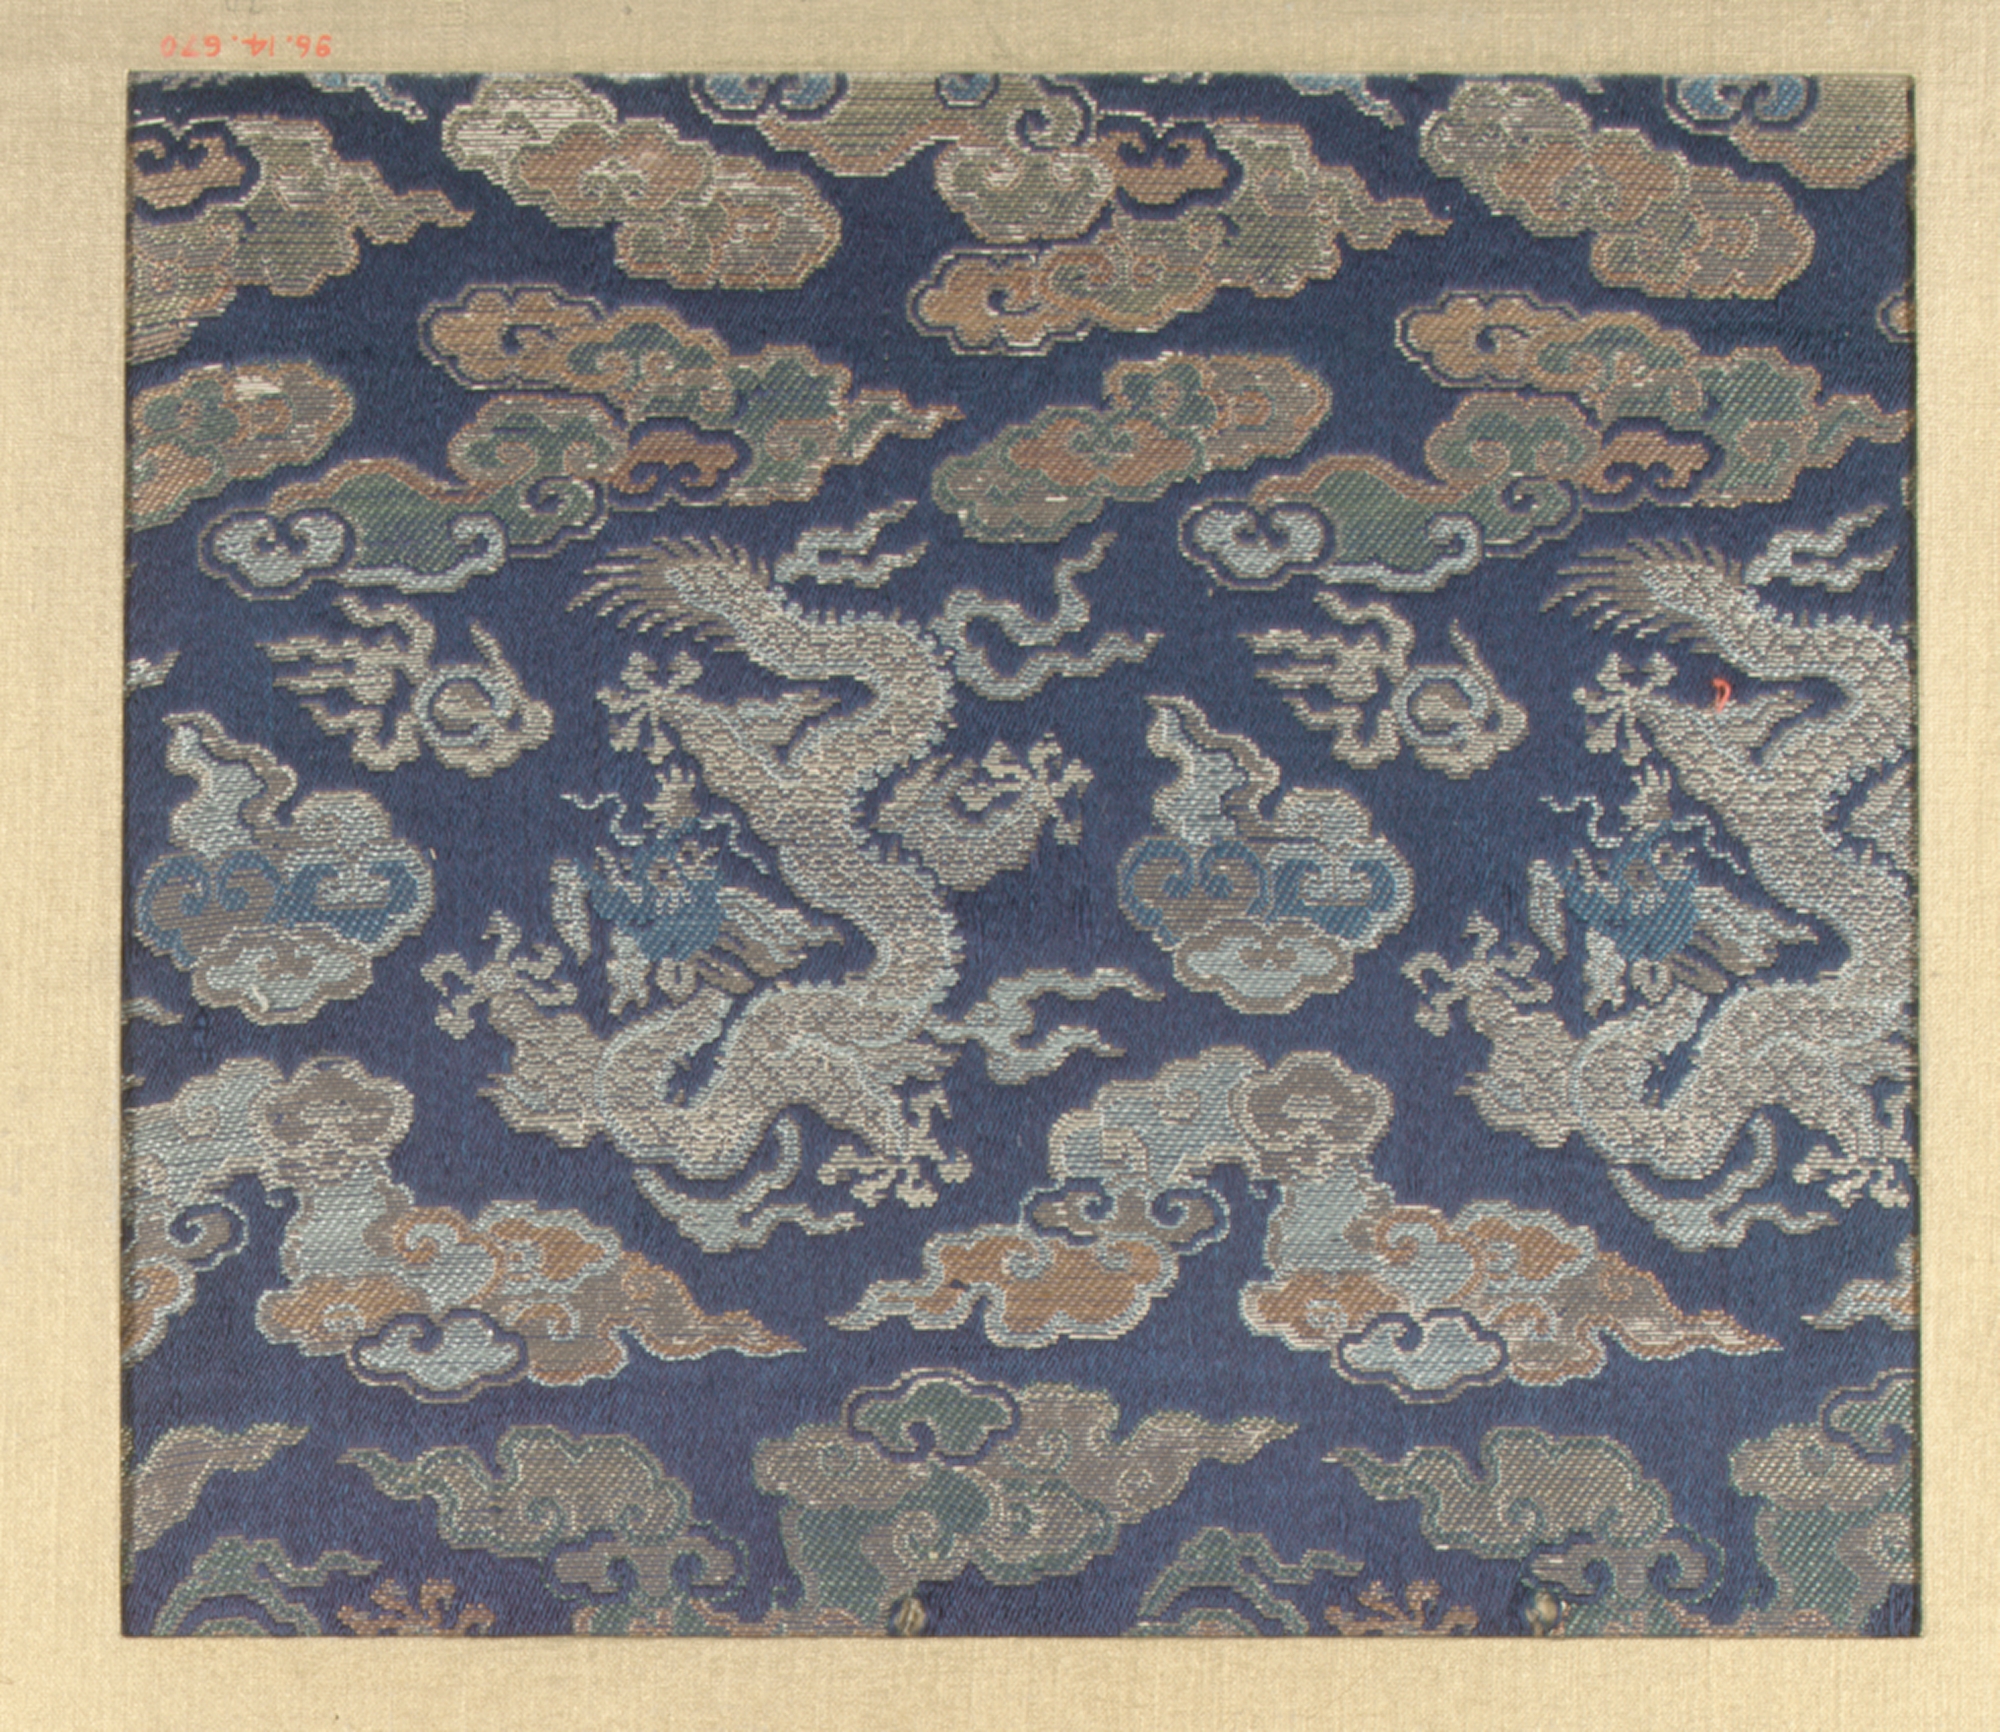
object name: piece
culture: chinese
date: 1701-1900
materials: silk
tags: dragons,clouds